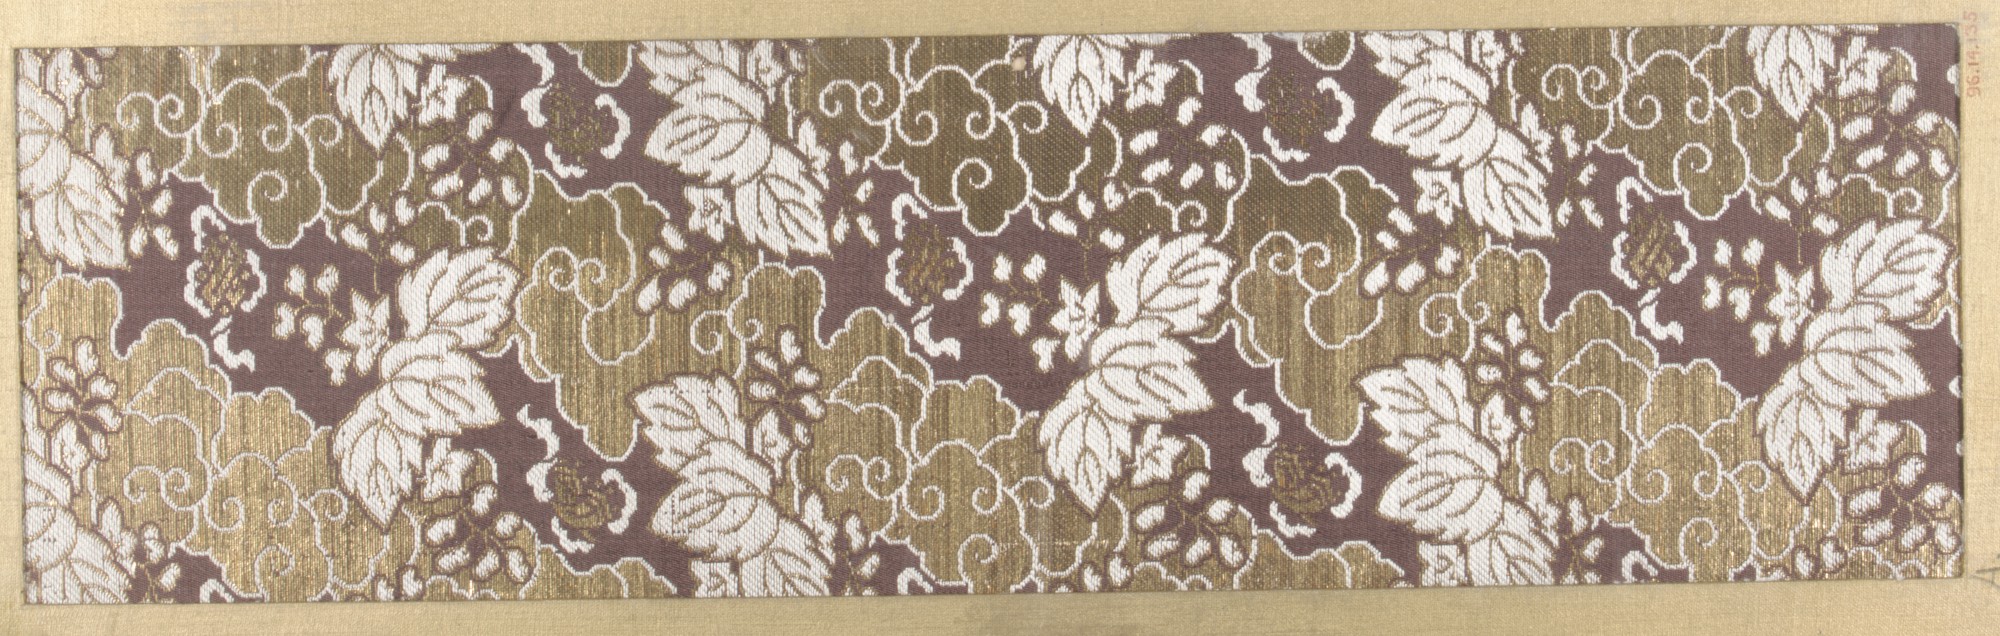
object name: piece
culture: japanese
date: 1701-1900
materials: silk